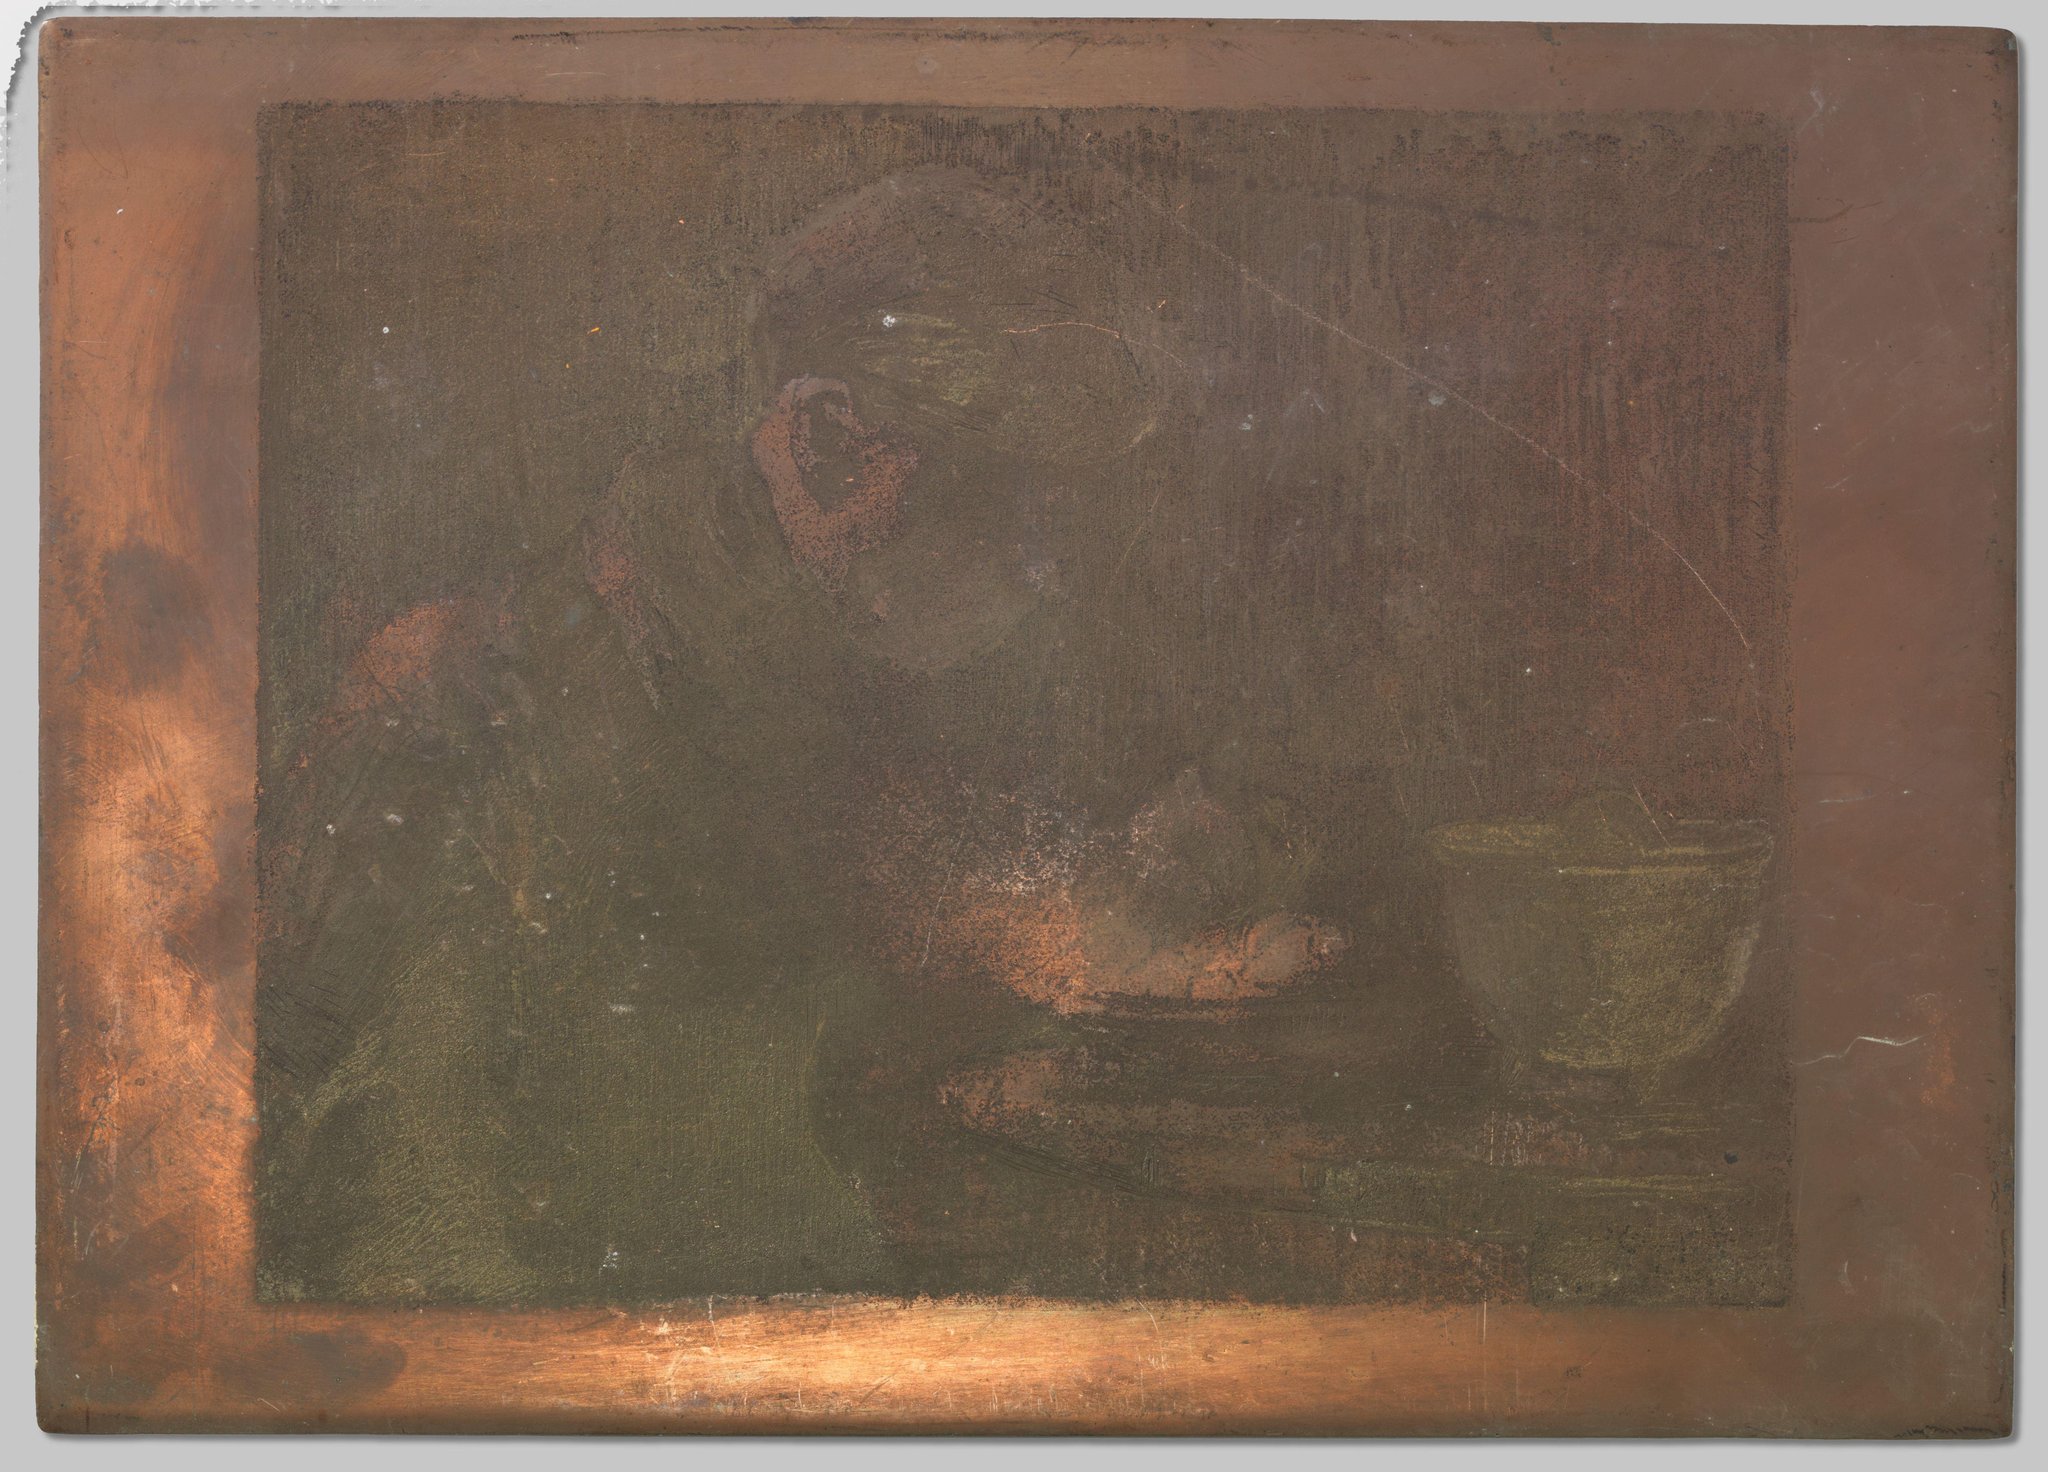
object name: copper plate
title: Aardappeletende jongen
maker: willem witsen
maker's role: draughtsman, painter, print maker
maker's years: 1860-1923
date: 1888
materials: copper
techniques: soft ground etching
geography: ewijkshoeve